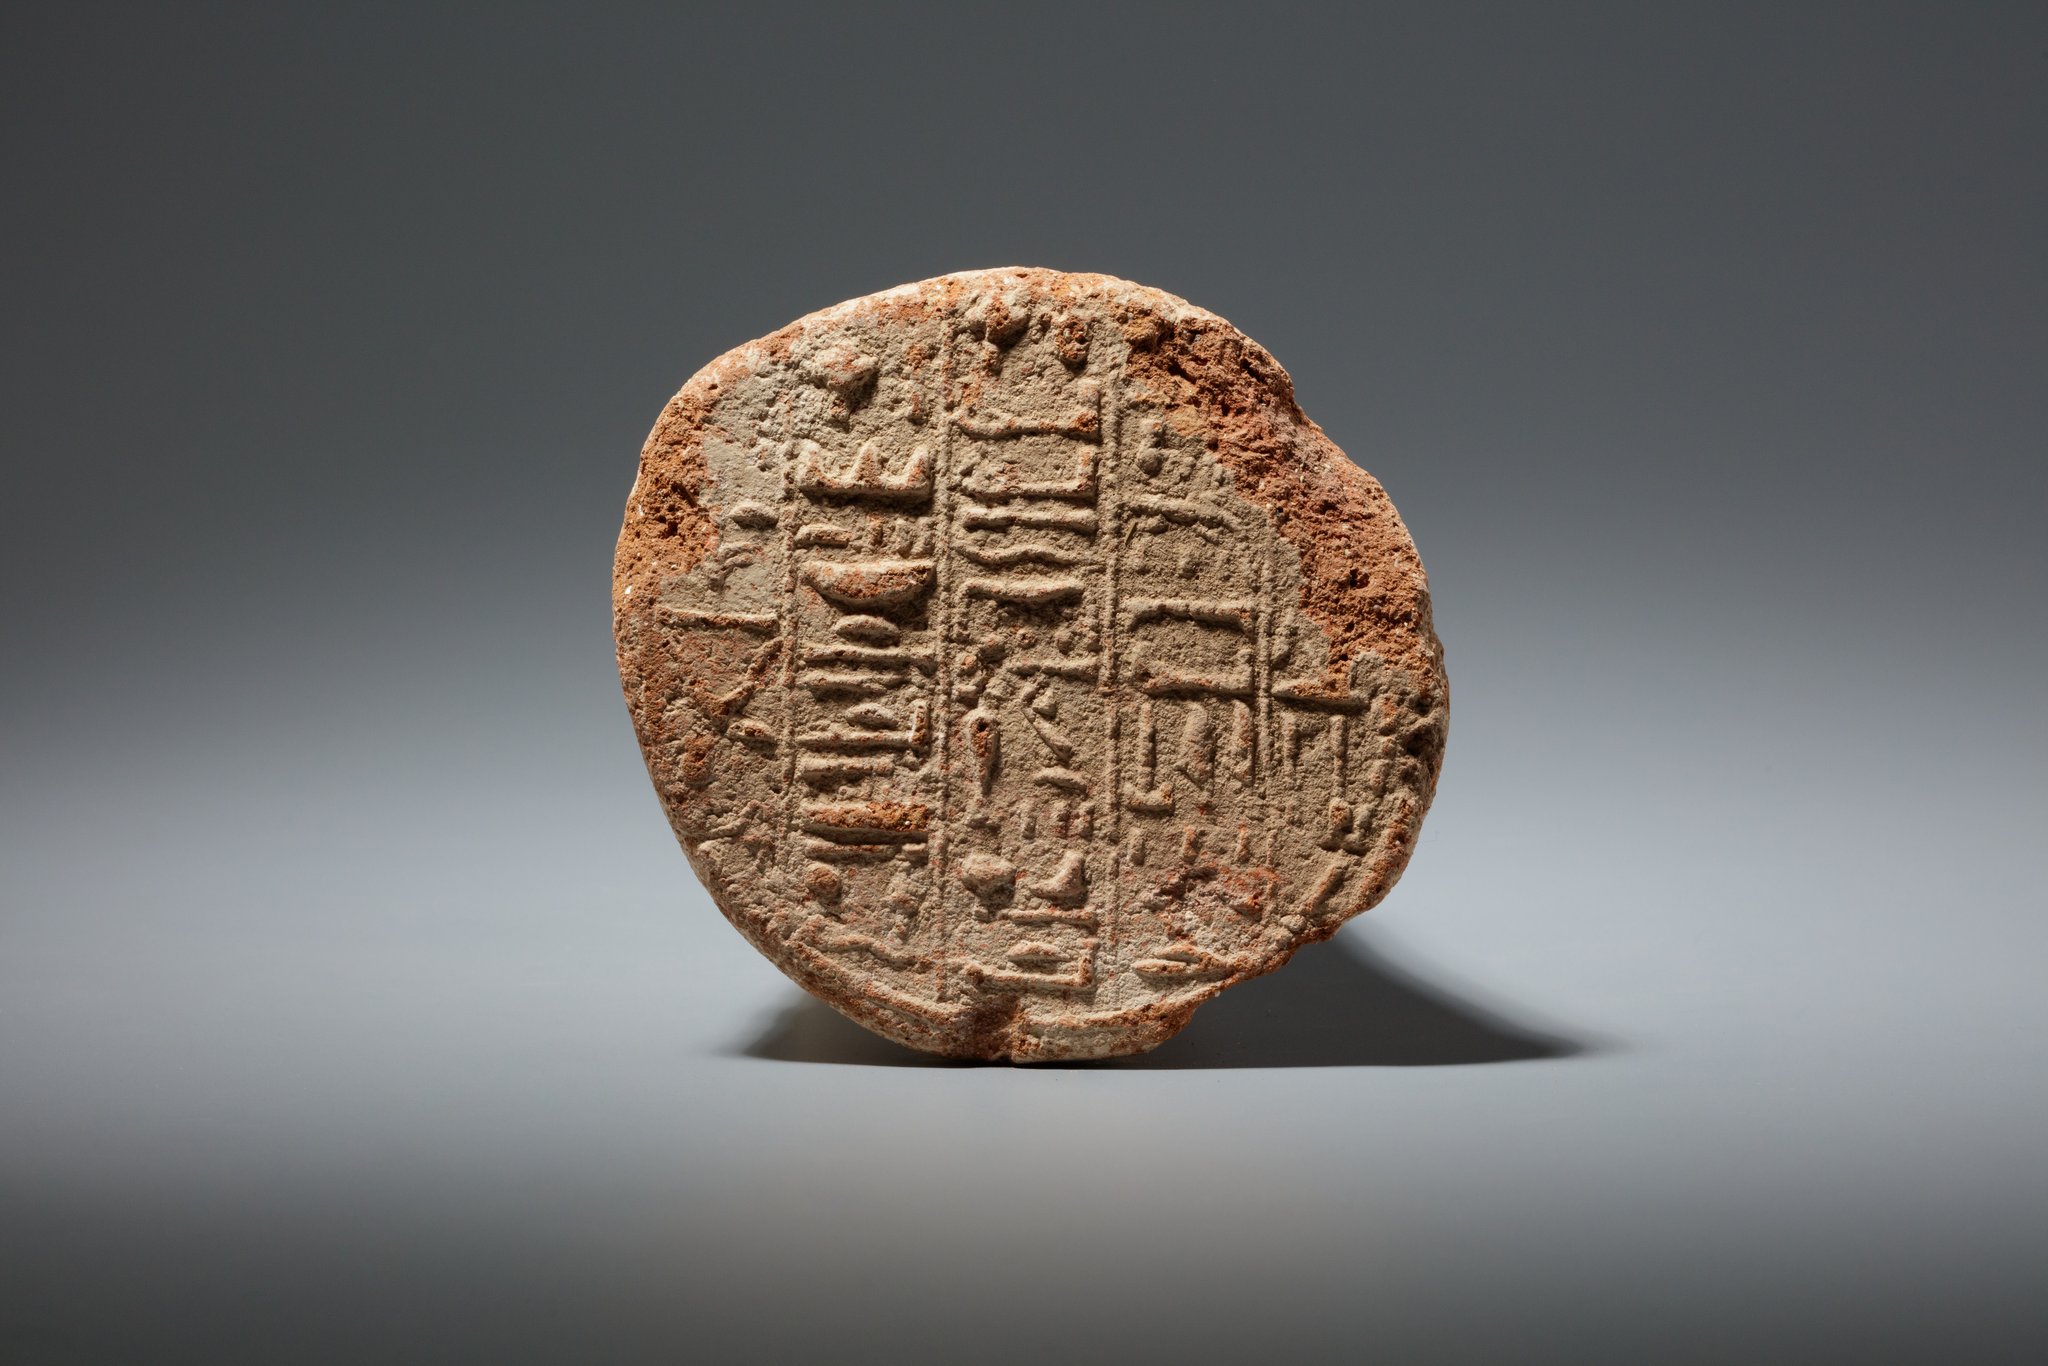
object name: cone, davy 4, didu, chief, medjay, messenger, king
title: Funerary Cone of the Chief of the Medjay Didu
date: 1479-1400 BCE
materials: pottery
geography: egypt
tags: hieroglyphs